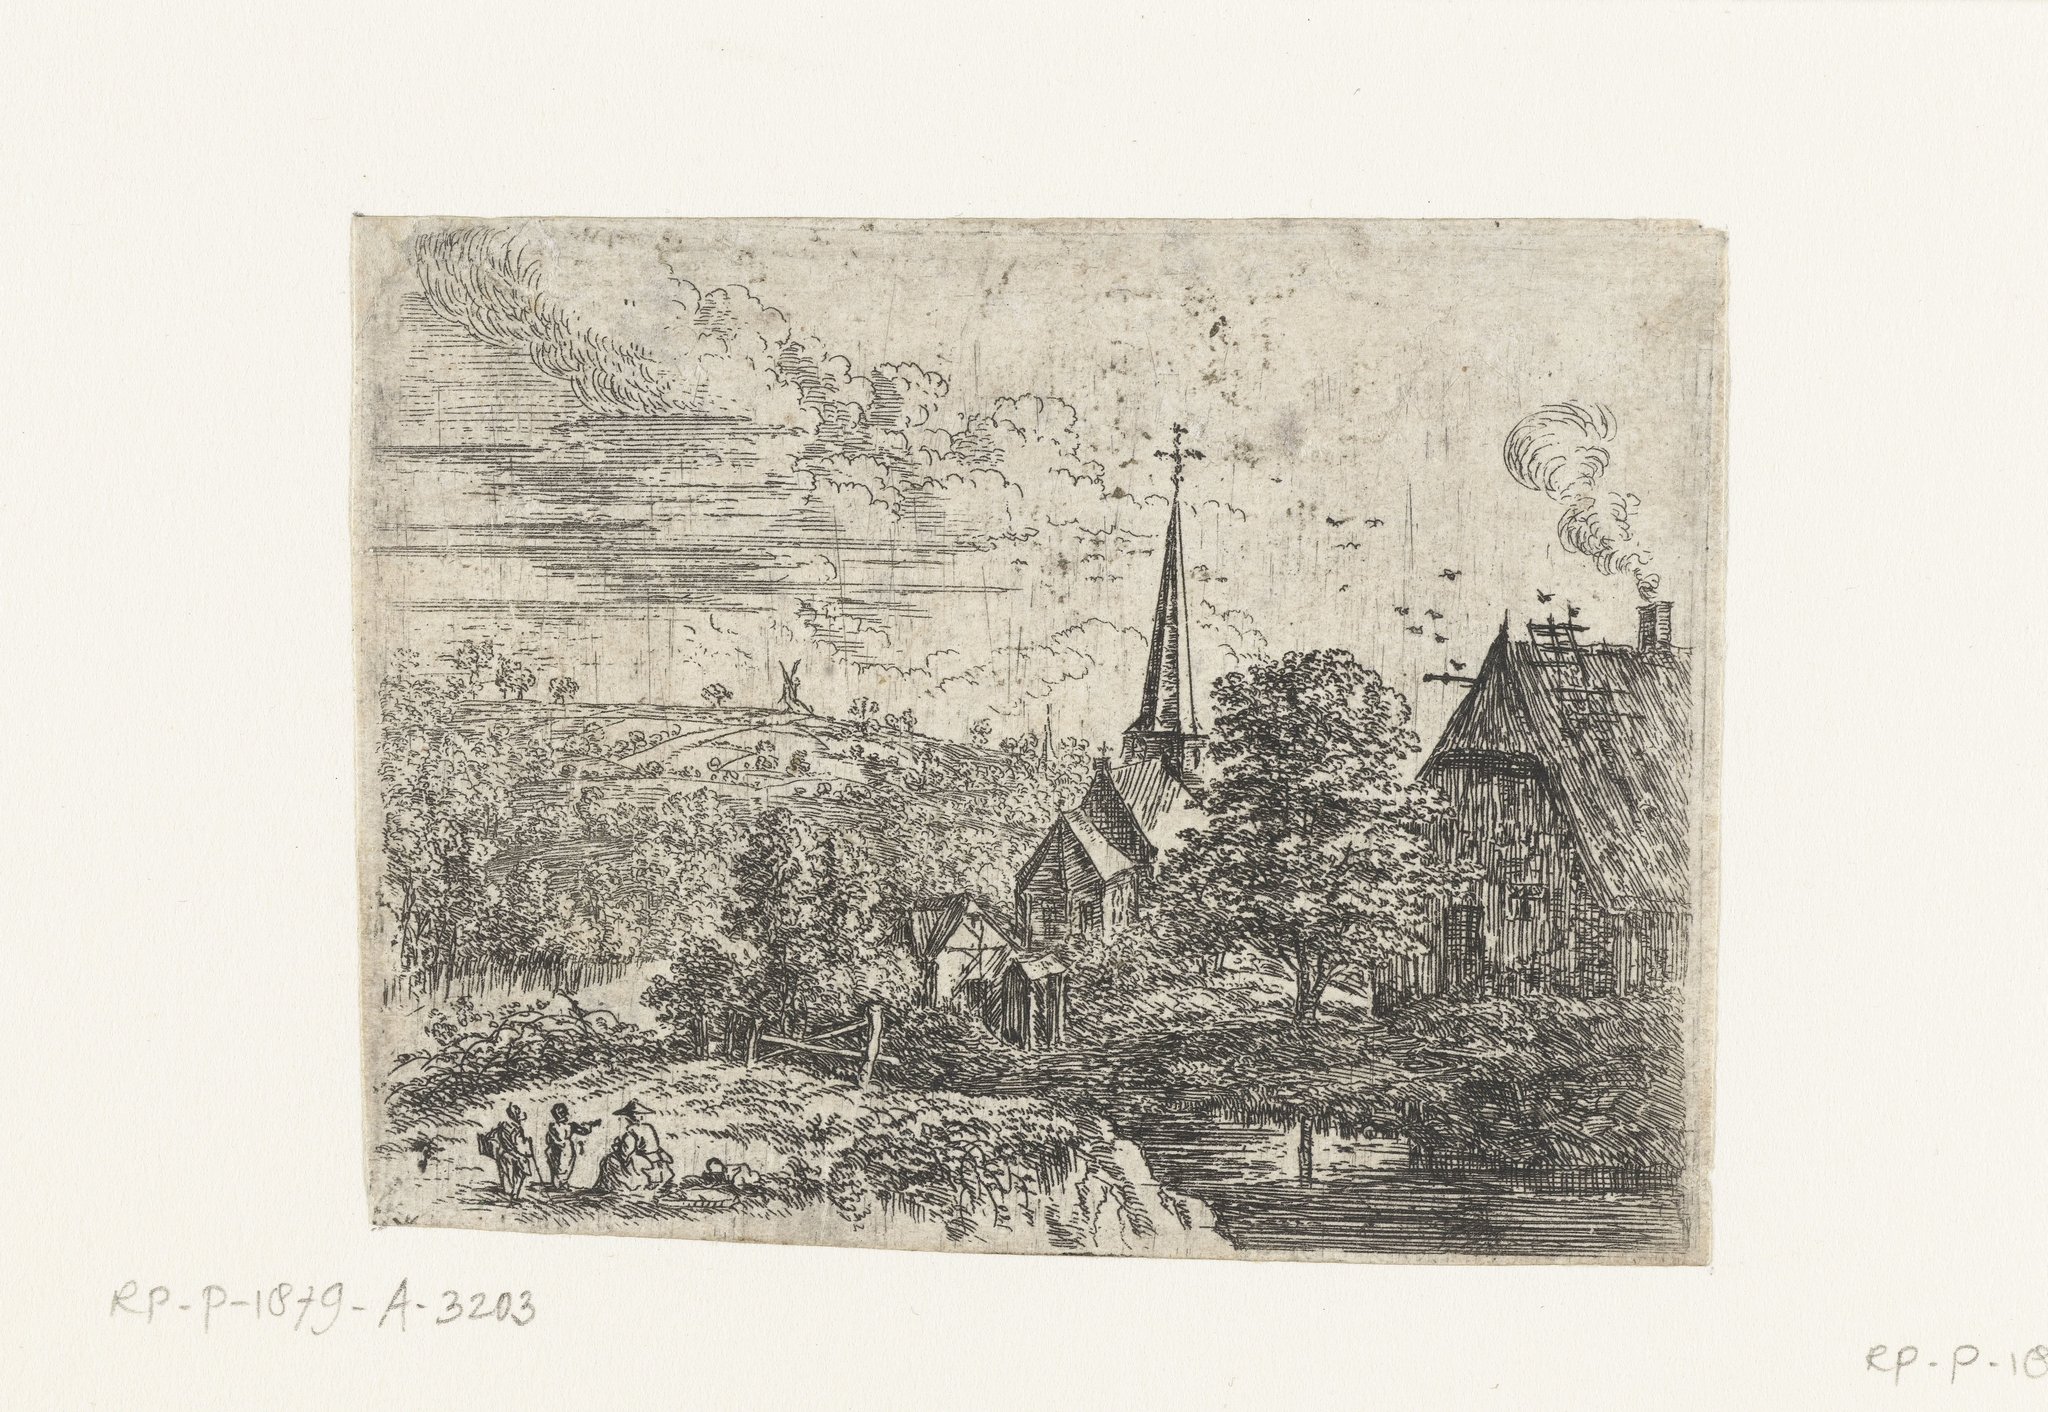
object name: print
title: Dorp gelegen aan een rivier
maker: lucas van uden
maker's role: draughtsman, print maker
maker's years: 1595-1673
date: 1605-1673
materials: paper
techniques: etching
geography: low countries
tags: river, village, church (exterior)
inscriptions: collector's mark: Lugt 2228, inscription: ‘F.D. 1842’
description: Uit een serie van twaalf. Landschap met een rivier stromend door een klein dorp met een kerk.